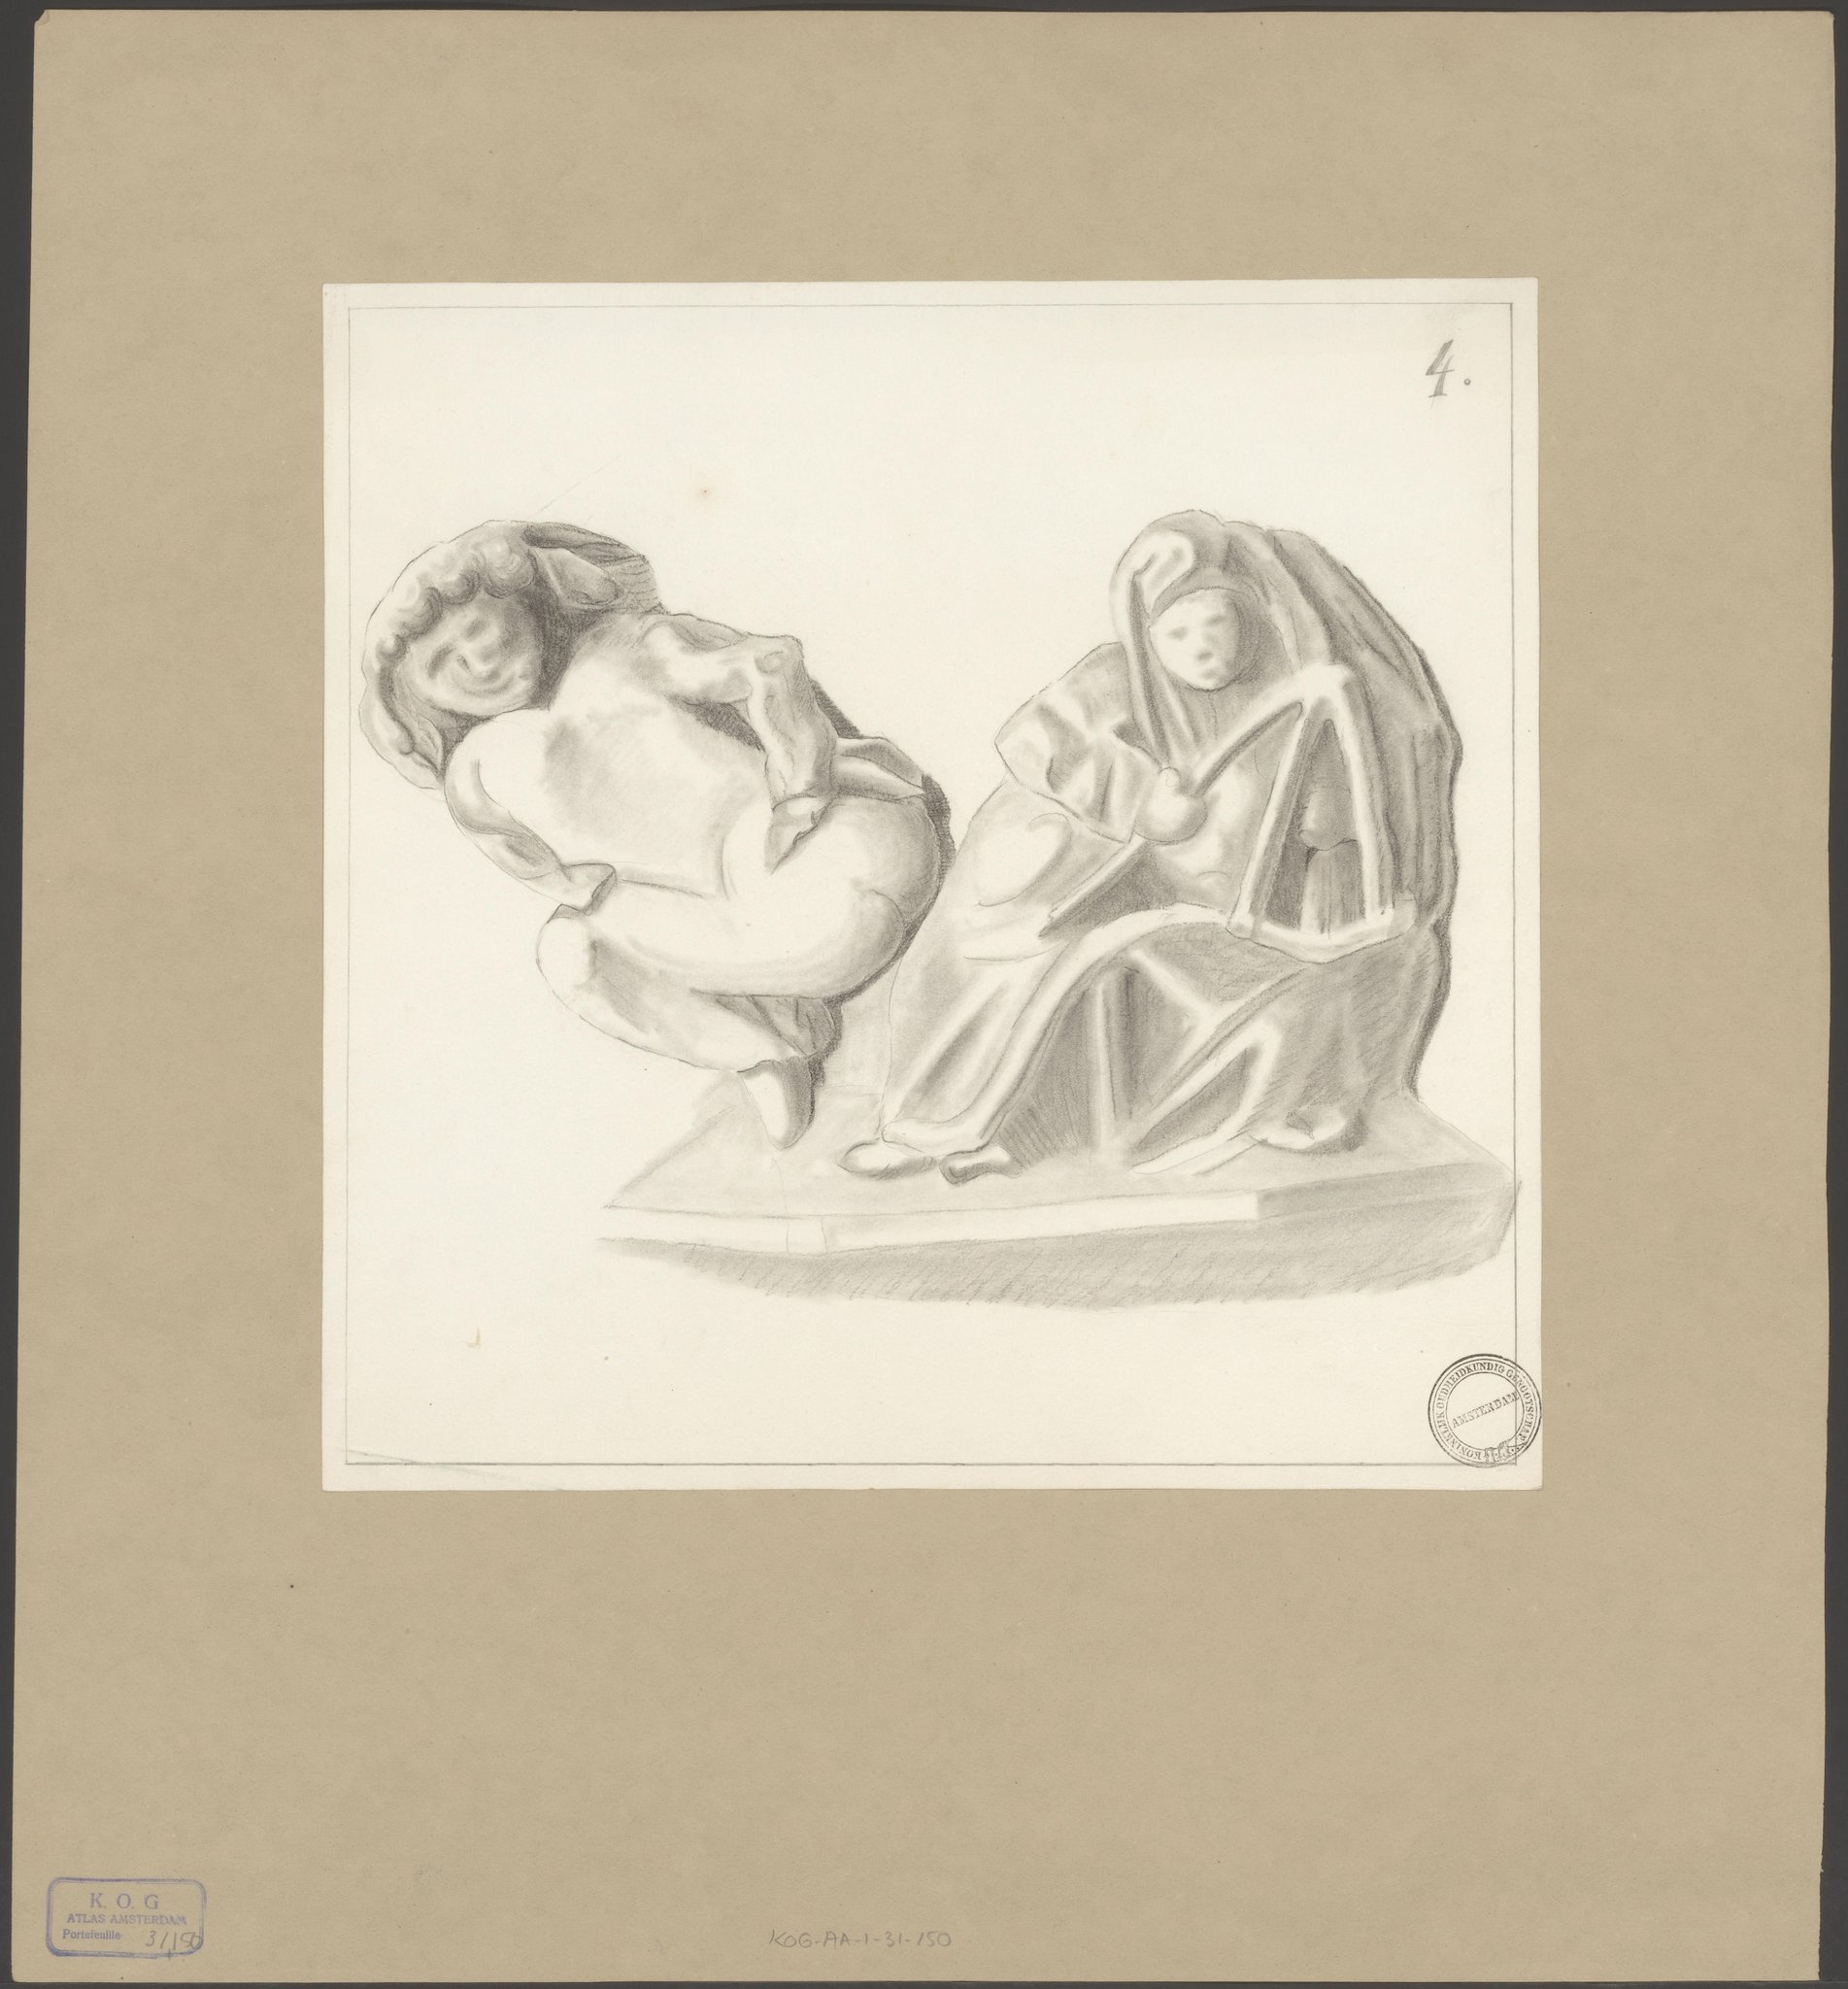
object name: print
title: Misericorde met twee figuren in de Oude Kerk te Amsterdam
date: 1880-1929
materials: paper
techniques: lithograph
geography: amsterdam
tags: misericords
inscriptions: collector's mark: ‘31,150’ Lugt 1641b, collector's mark: ‘Koninklijk Oudheidkundig Genootschap / Amsterdam’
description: Een zittende vrouw rolt de uitwerpselen op van een gehurkte naakte man naast haar. Rechtsboven genummerd: 4. Onderwerpsrubriek binnen de Atlas Amsterdam: Kerkwezen: Hervormde Gemeente: Oude Kerk, koorgestoelte.